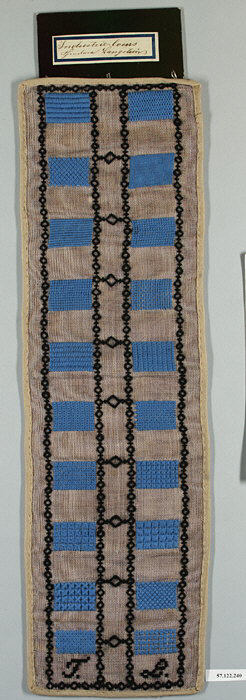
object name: sampler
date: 1801-1900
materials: canvas, wool